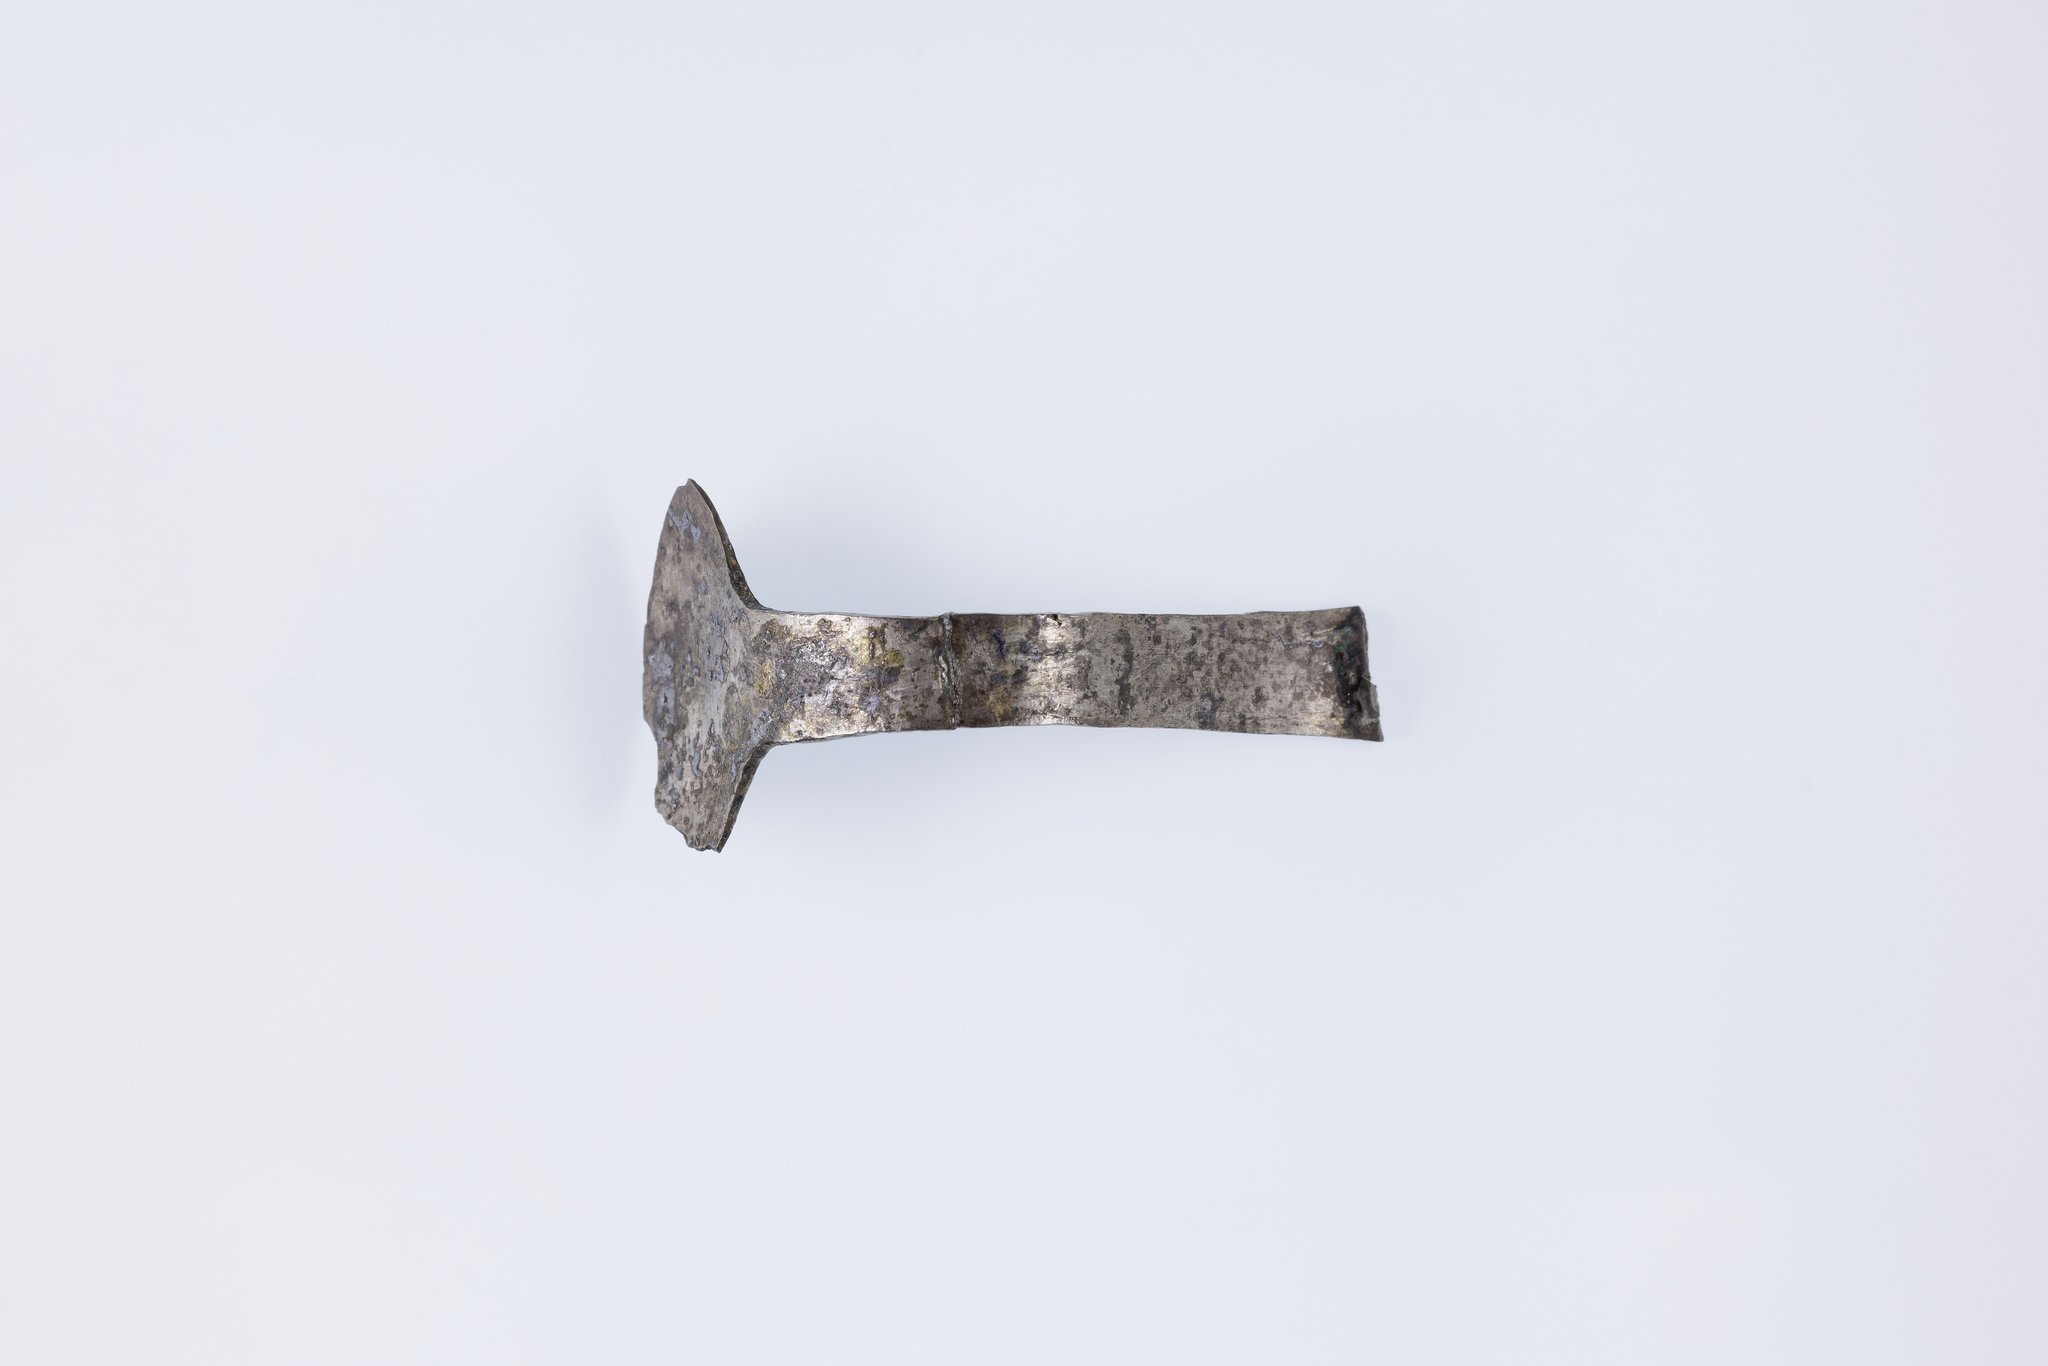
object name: strainer handle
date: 1295-1070 BCE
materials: silver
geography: egypt